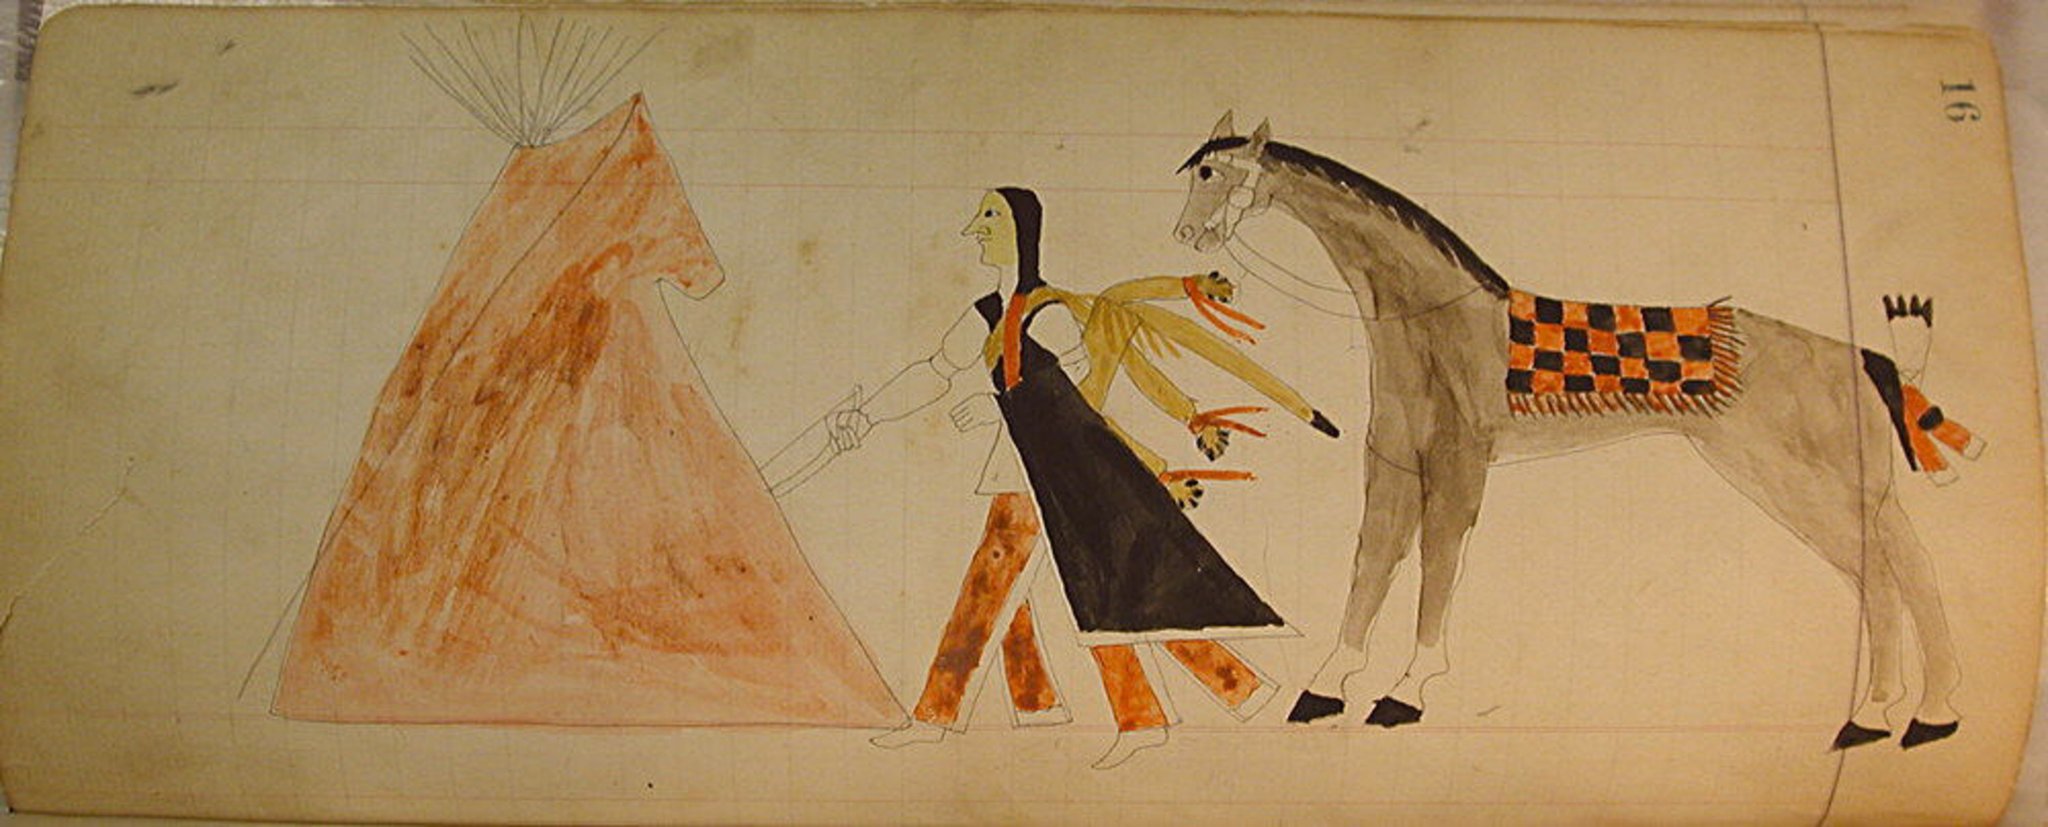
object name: drawing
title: Maffet Ledger: Indian on horseback, soldier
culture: cheyenne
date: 1874-1881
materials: crayon, graphite, paper, watercolor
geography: united states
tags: tents,soldiers,horses